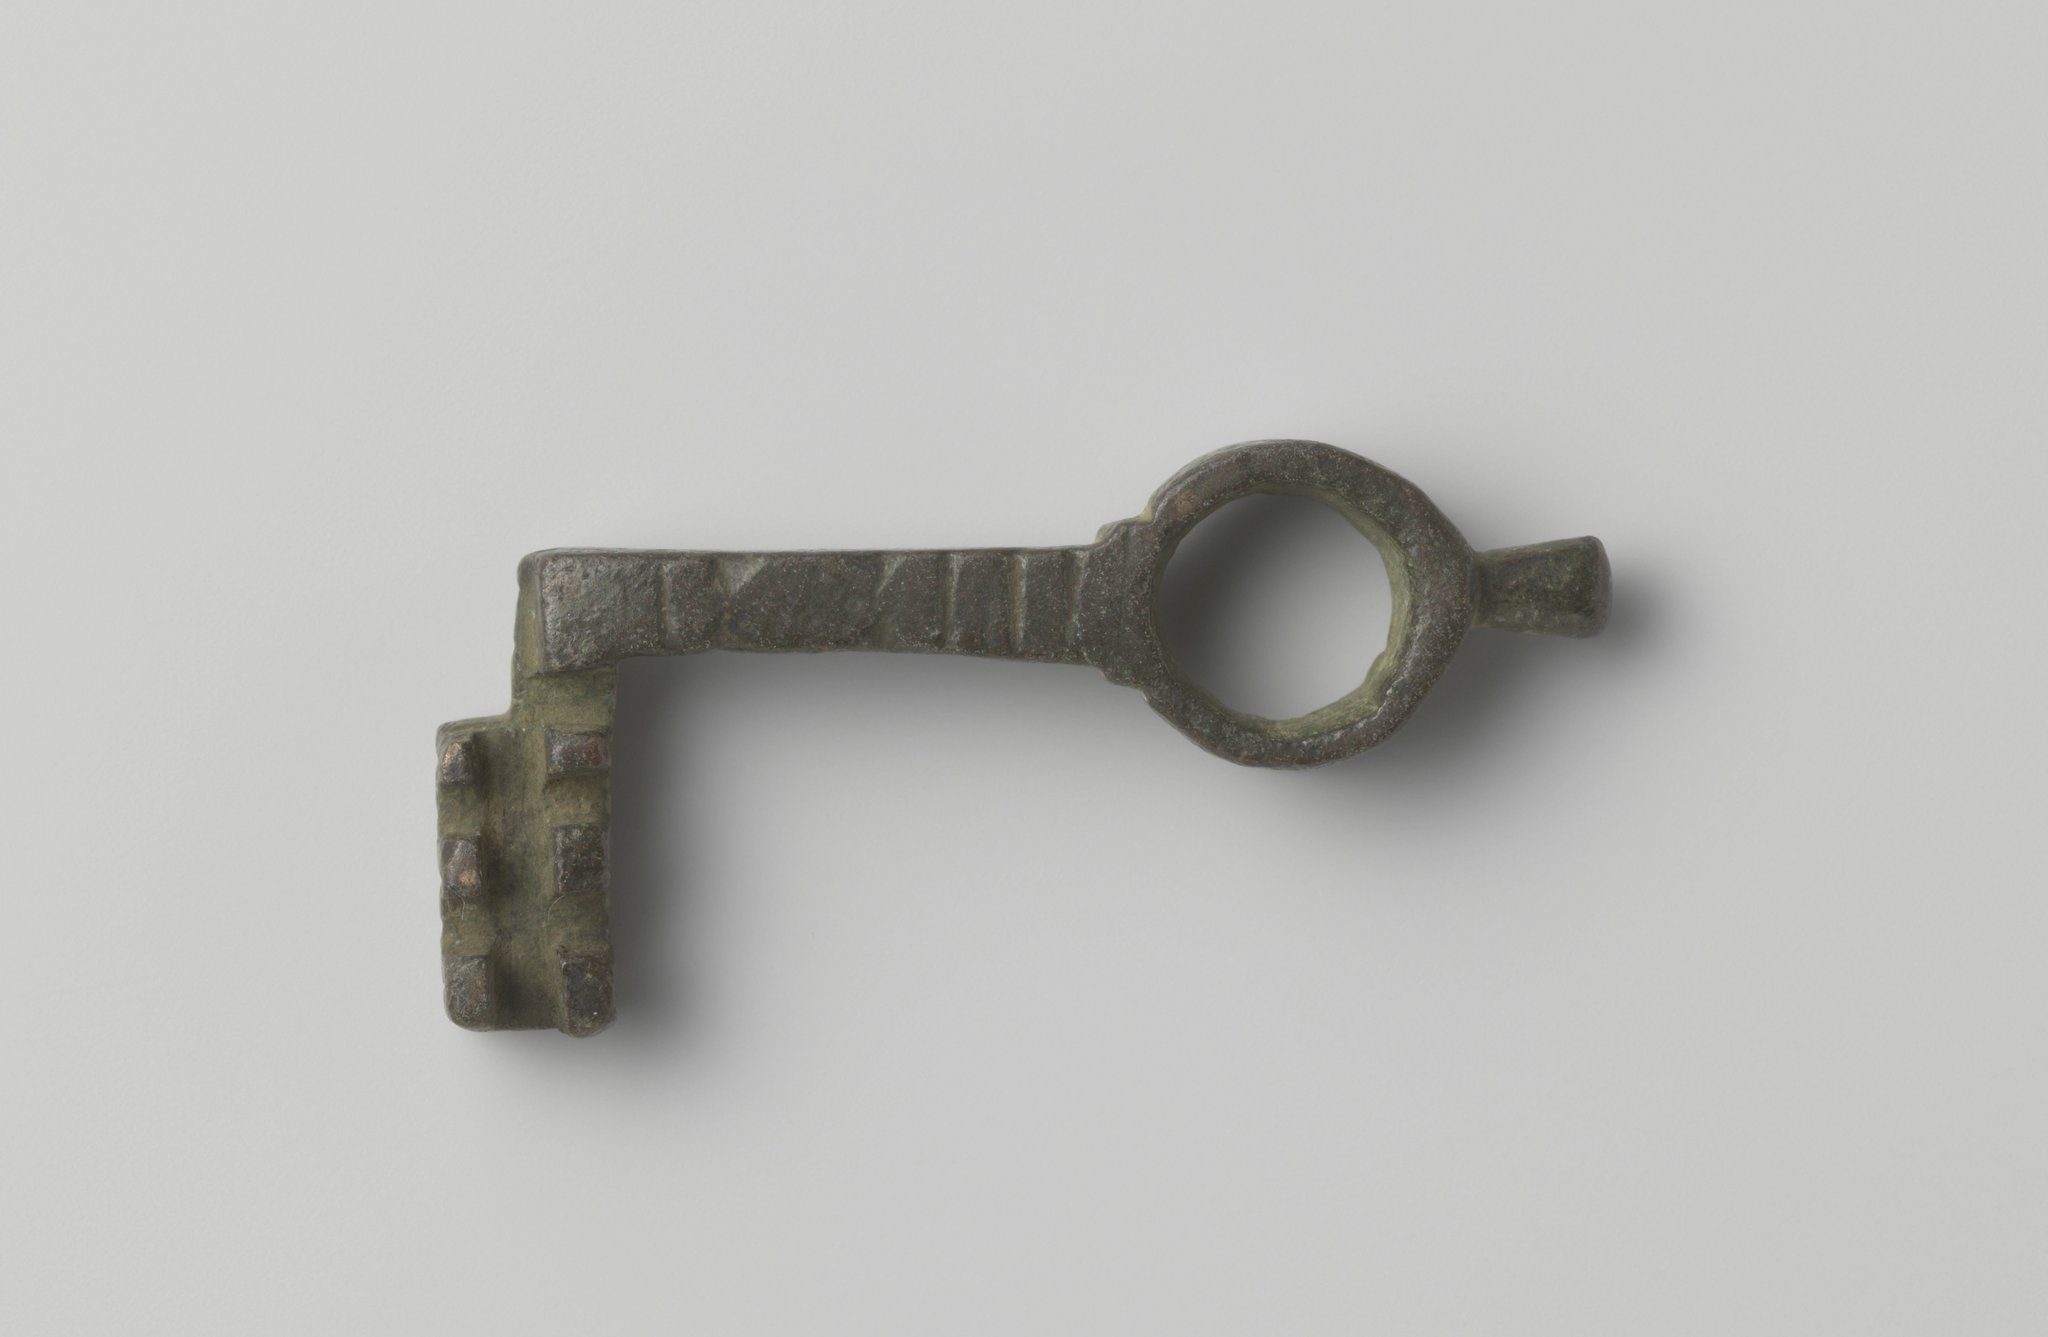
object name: key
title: Sleutel van brons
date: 300-500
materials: bronze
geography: france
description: Bronzen sleutel met dwarsgestelde baard, ronde ring, waarop een punt.